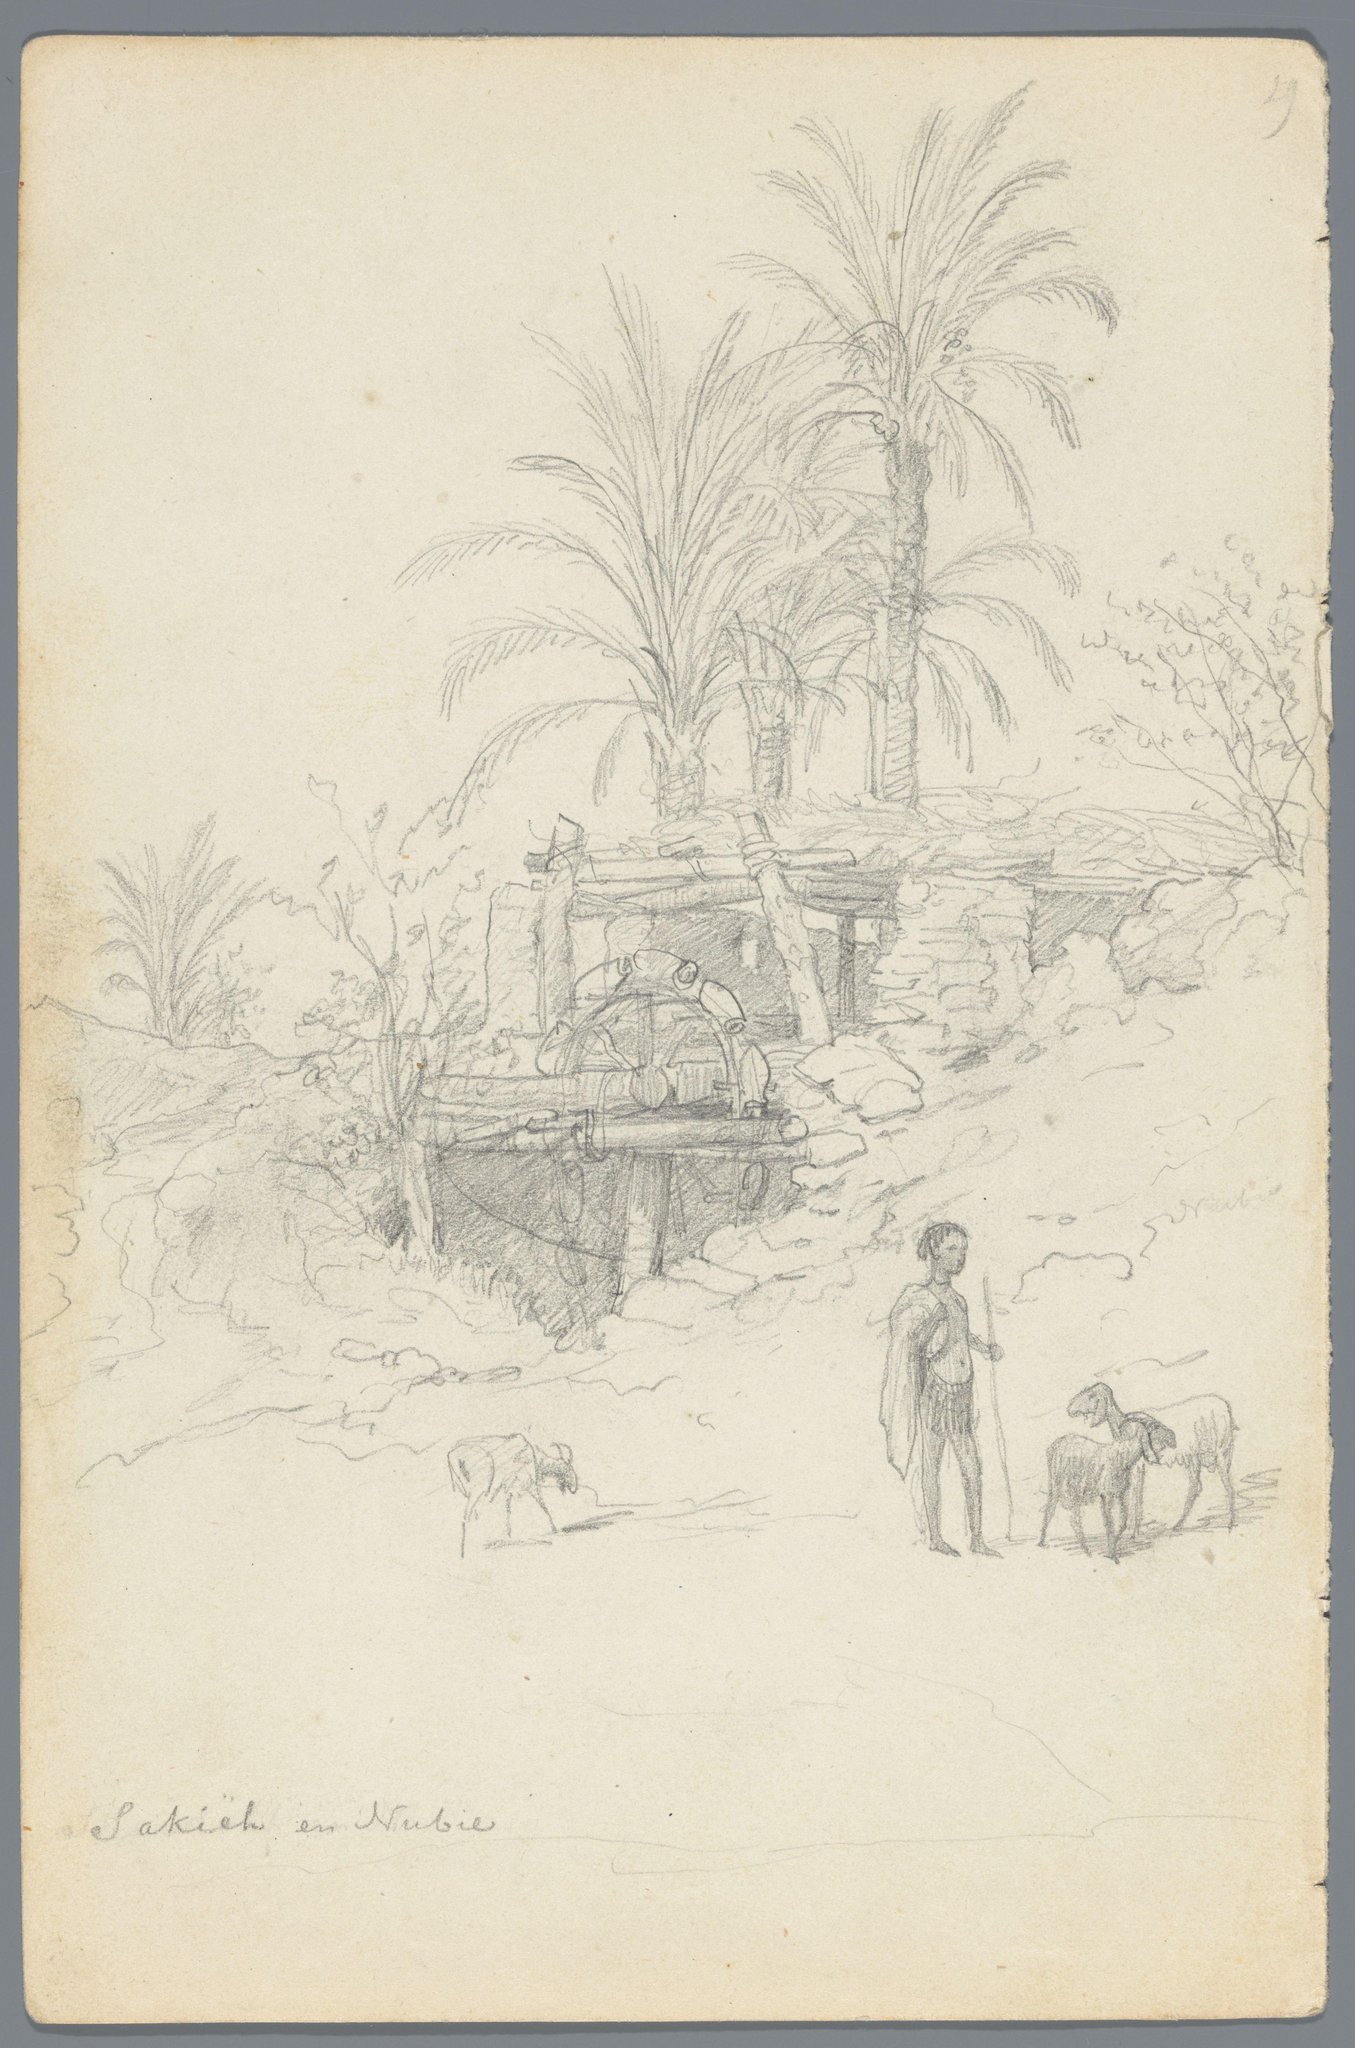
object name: sketchbook leaf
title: Gezicht op de oase Sakieh in Nubië, met waterput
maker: willem de famars testas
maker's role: draughtsman, painter, print maker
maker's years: 1834-1896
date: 1858-1859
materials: pencil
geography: egypt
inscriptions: inscription: ‘Sakieh en Nubie’, inscription: ‘29’